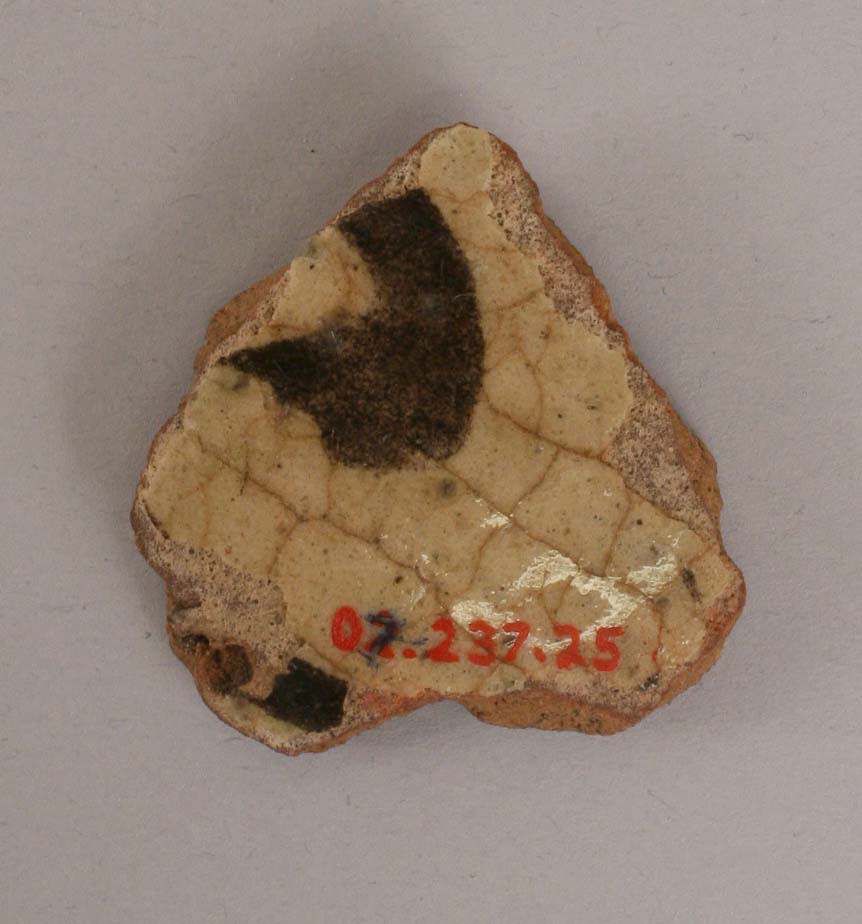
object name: fragment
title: Ceramic Fragment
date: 1301-1500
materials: earthenware, glaze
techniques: painting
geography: egypt